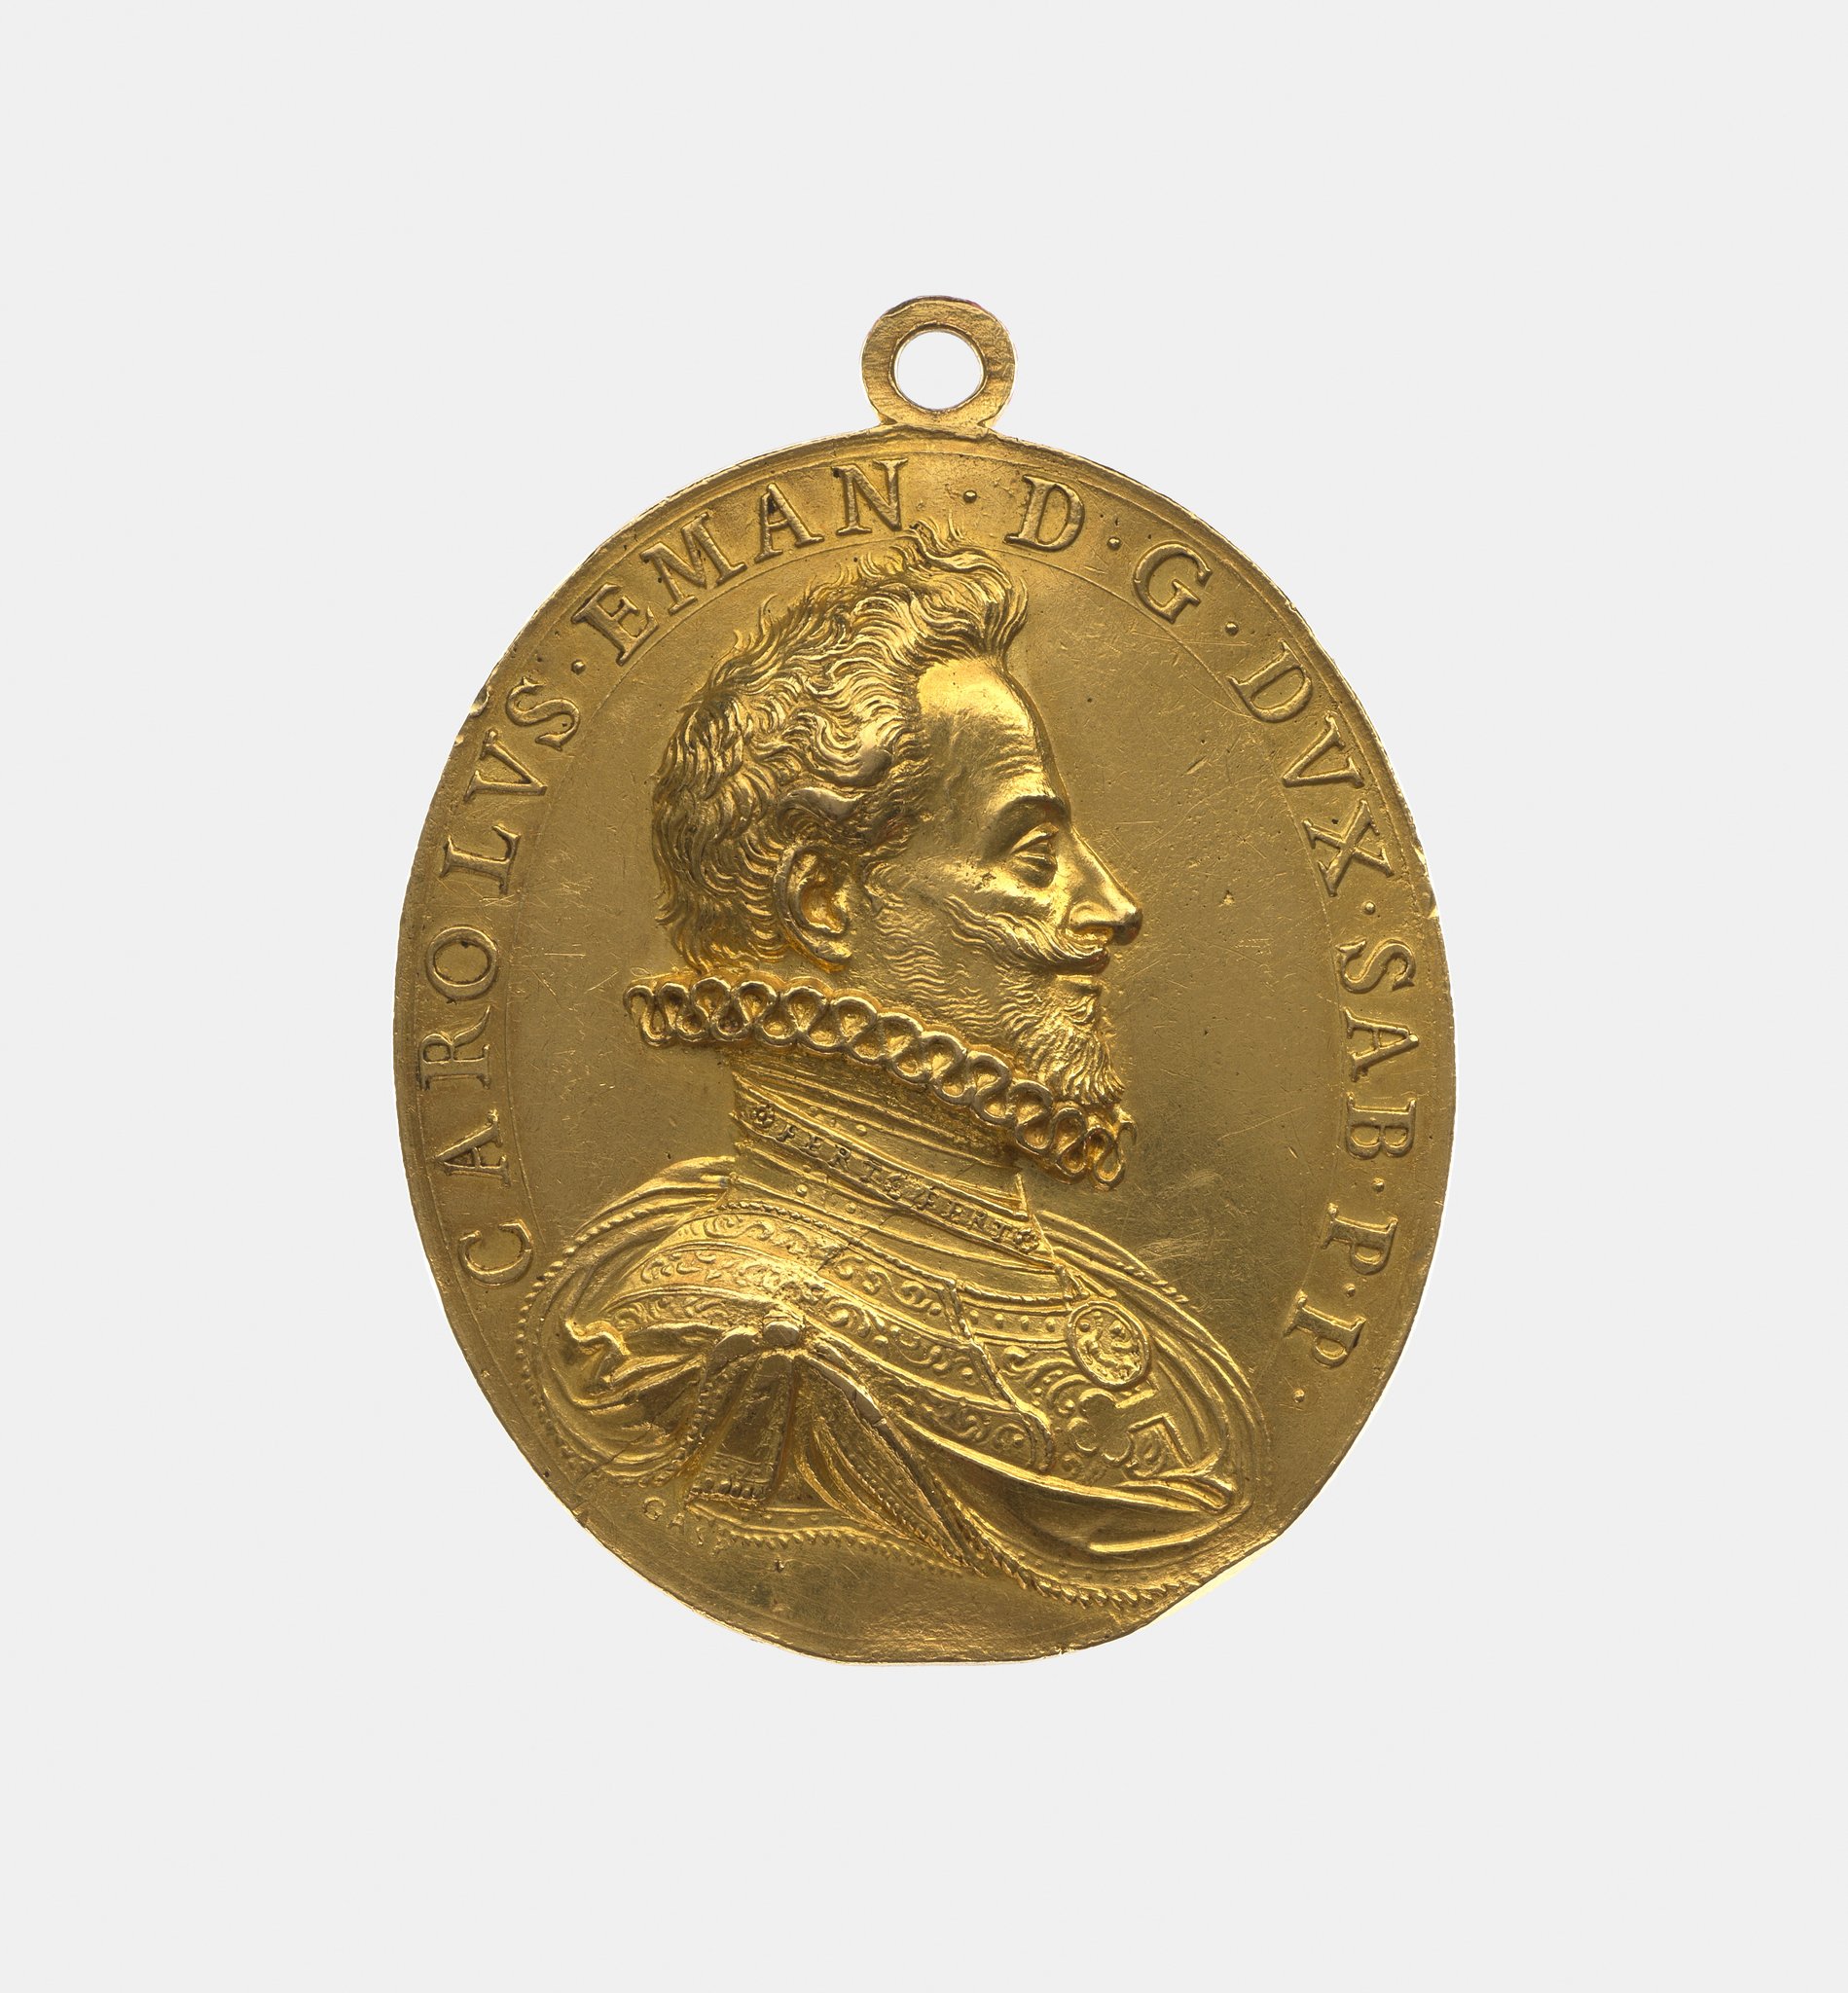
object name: medal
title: Charles Emanuel I 1562-1630, Duke of Savoy 1580-1630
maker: gasparo mola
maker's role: artist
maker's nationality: italian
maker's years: 1575-1640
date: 1606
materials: gold